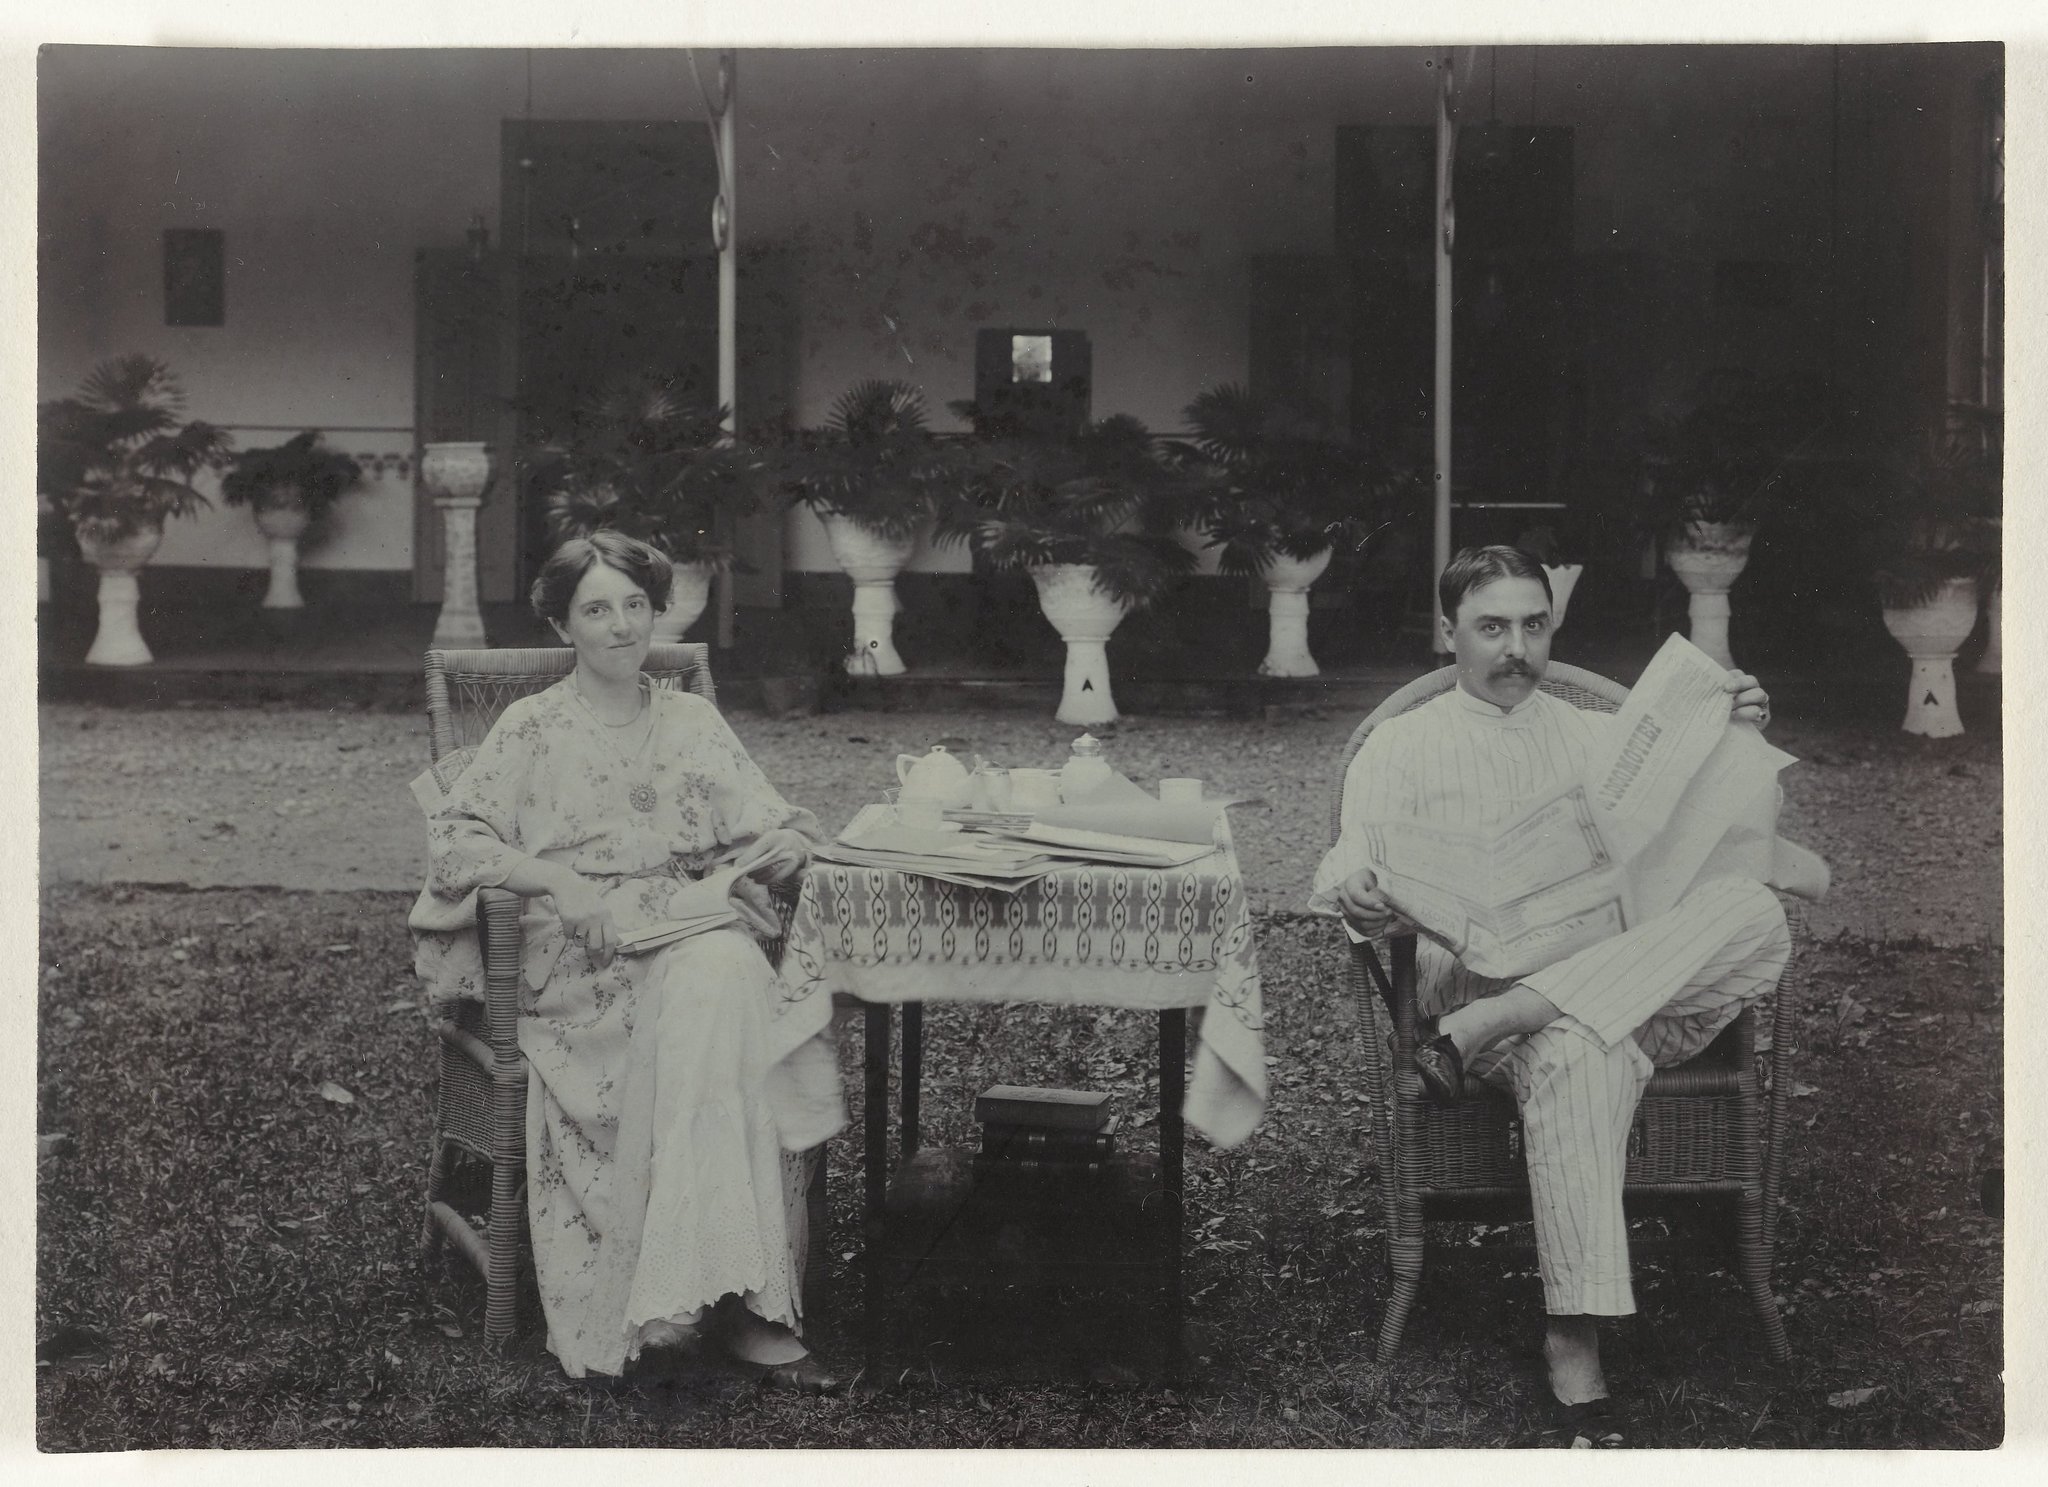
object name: photograph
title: Het echtpaar Letterie in de tuin van hun woning in Mojosari in Indië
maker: Anonymous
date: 1913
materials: photographic support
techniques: photography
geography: mojosari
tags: letterie, mojosari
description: Het echtpaar Letterie in de tuin van hun woning in Mojosari in Indië. Echtpaar is aan de thee en leest de krant 'de Locomotief'.